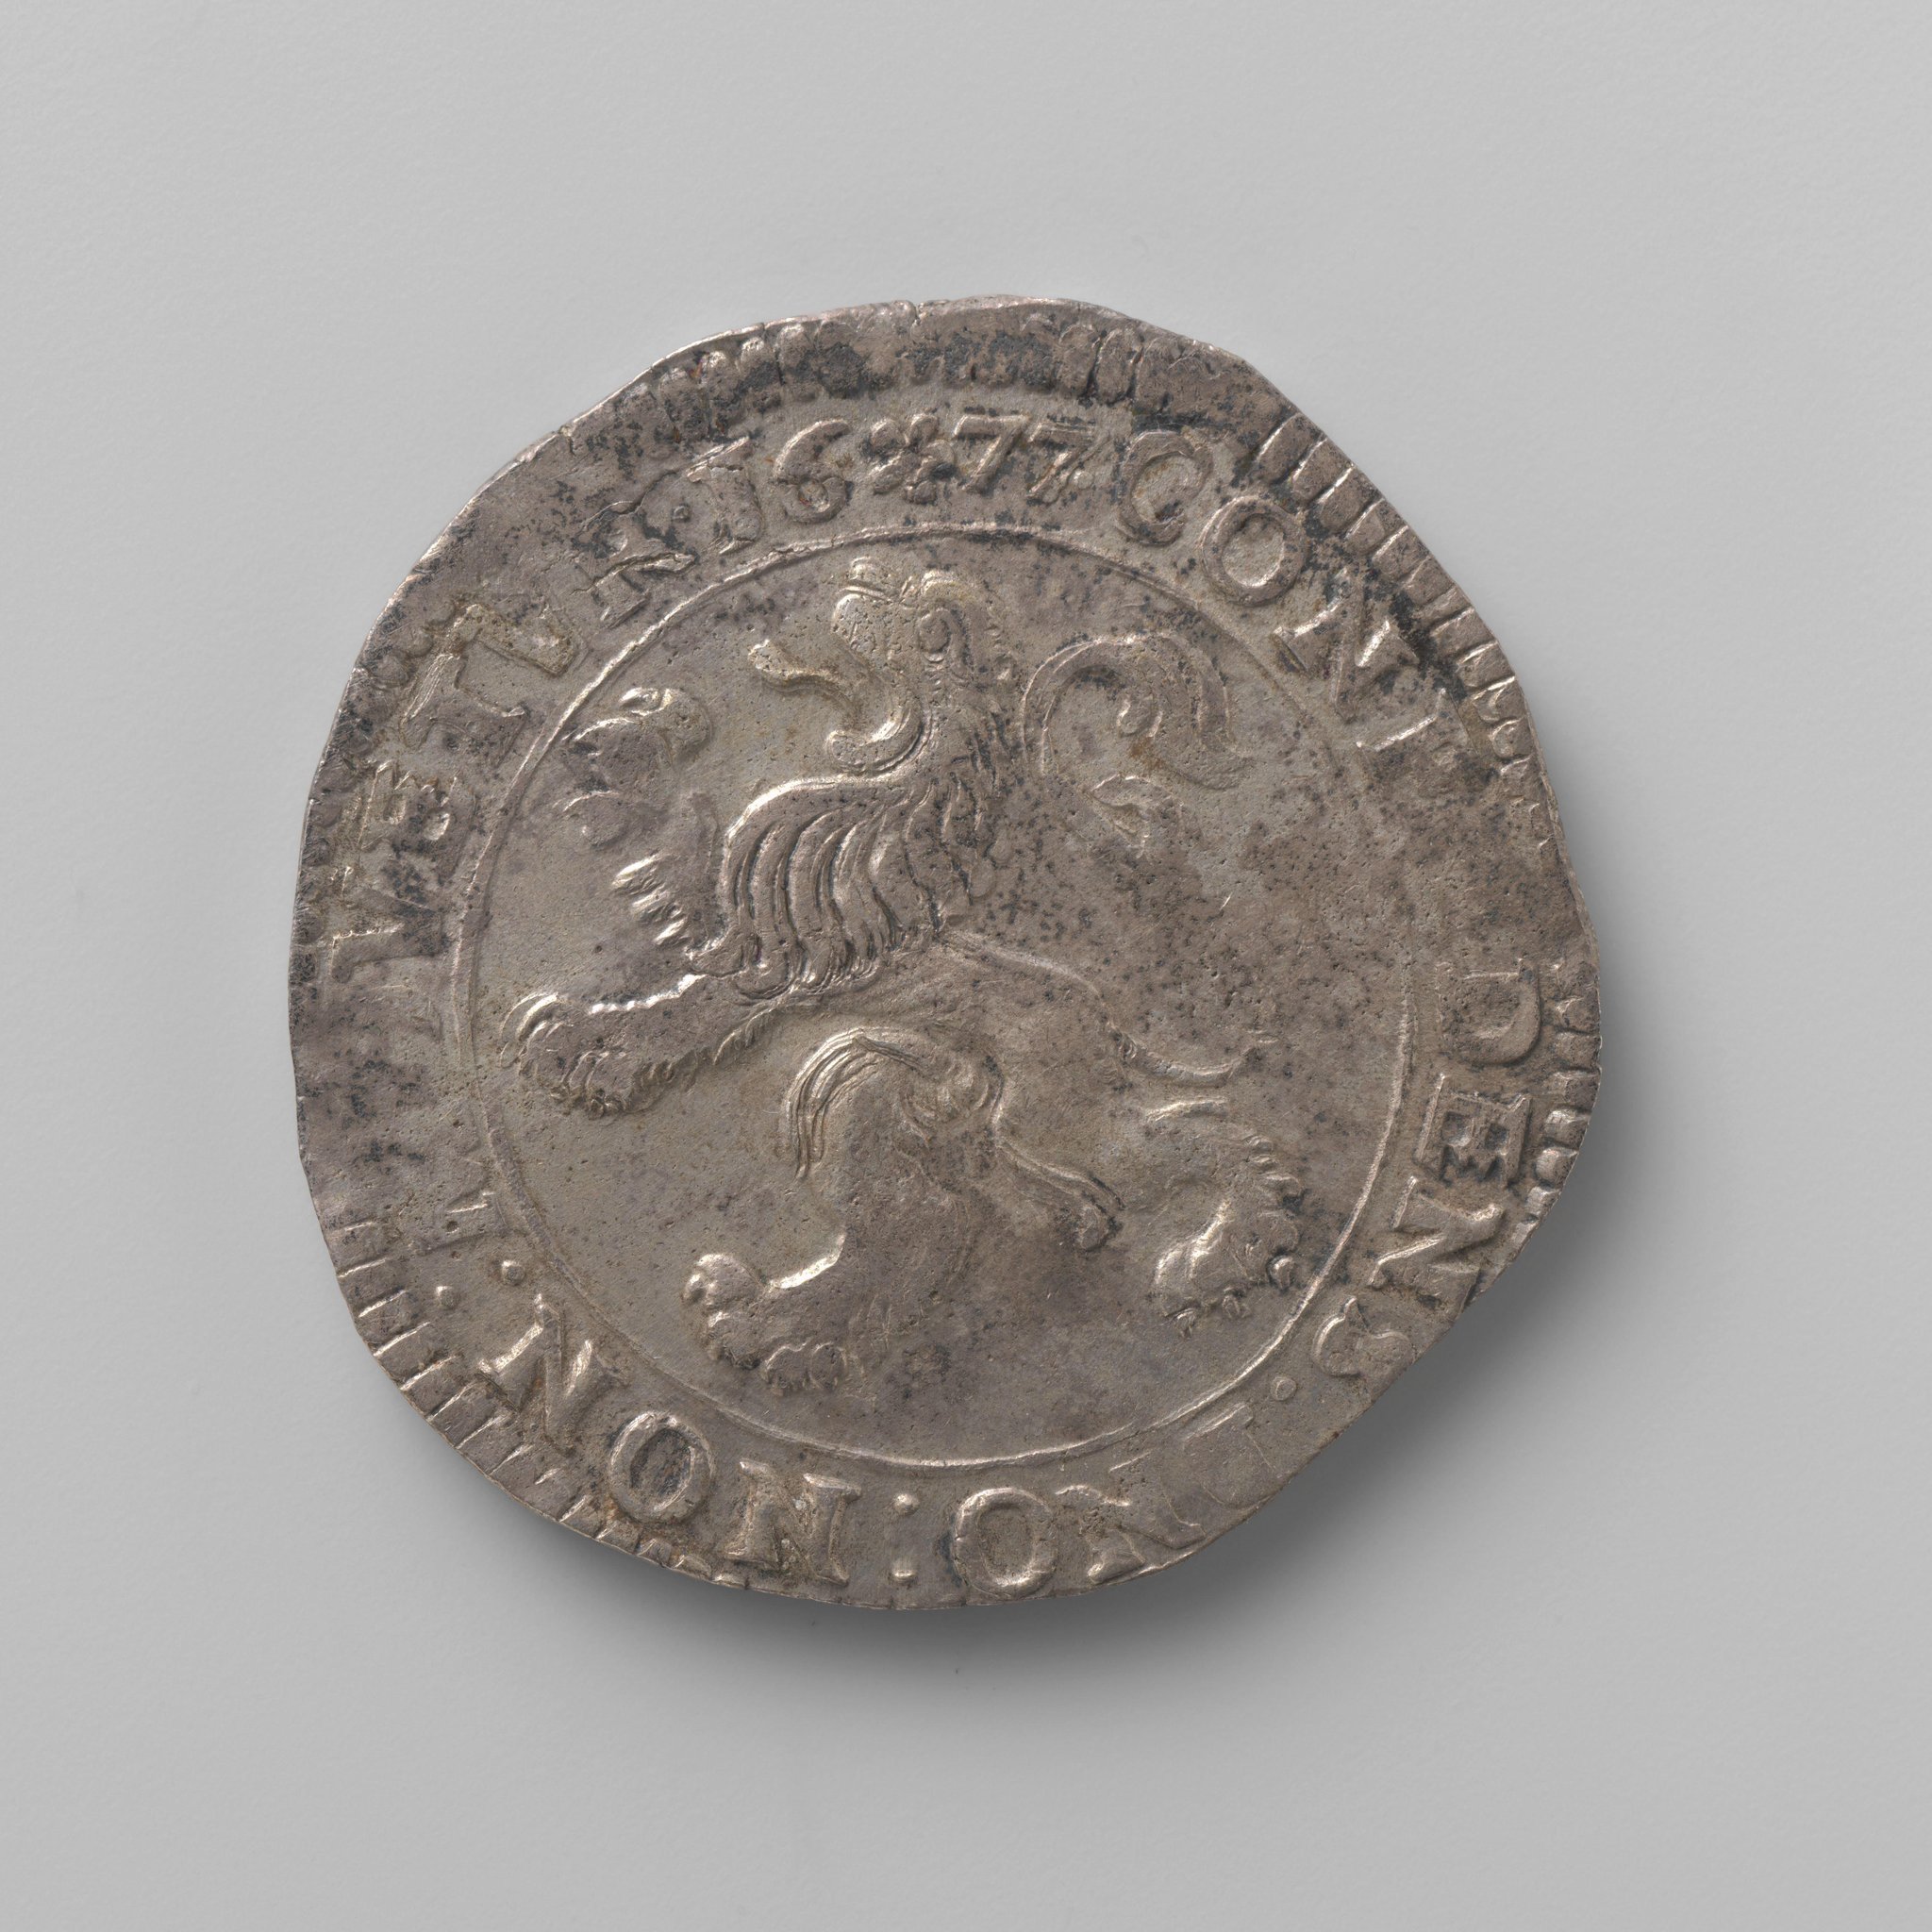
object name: leeuwendaalder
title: Overijssel, Nederlandse rijksdaalder, 1677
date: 1677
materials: silver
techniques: striking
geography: kampen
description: Zilveren munt. Voorzijde: gehelmde, naar rechts kijkende ridder, voor zich wapenschild met leeuw aan lint. Keerzijde: klimmende leeuw naar links. Jaartal bovenaan in omschrift.